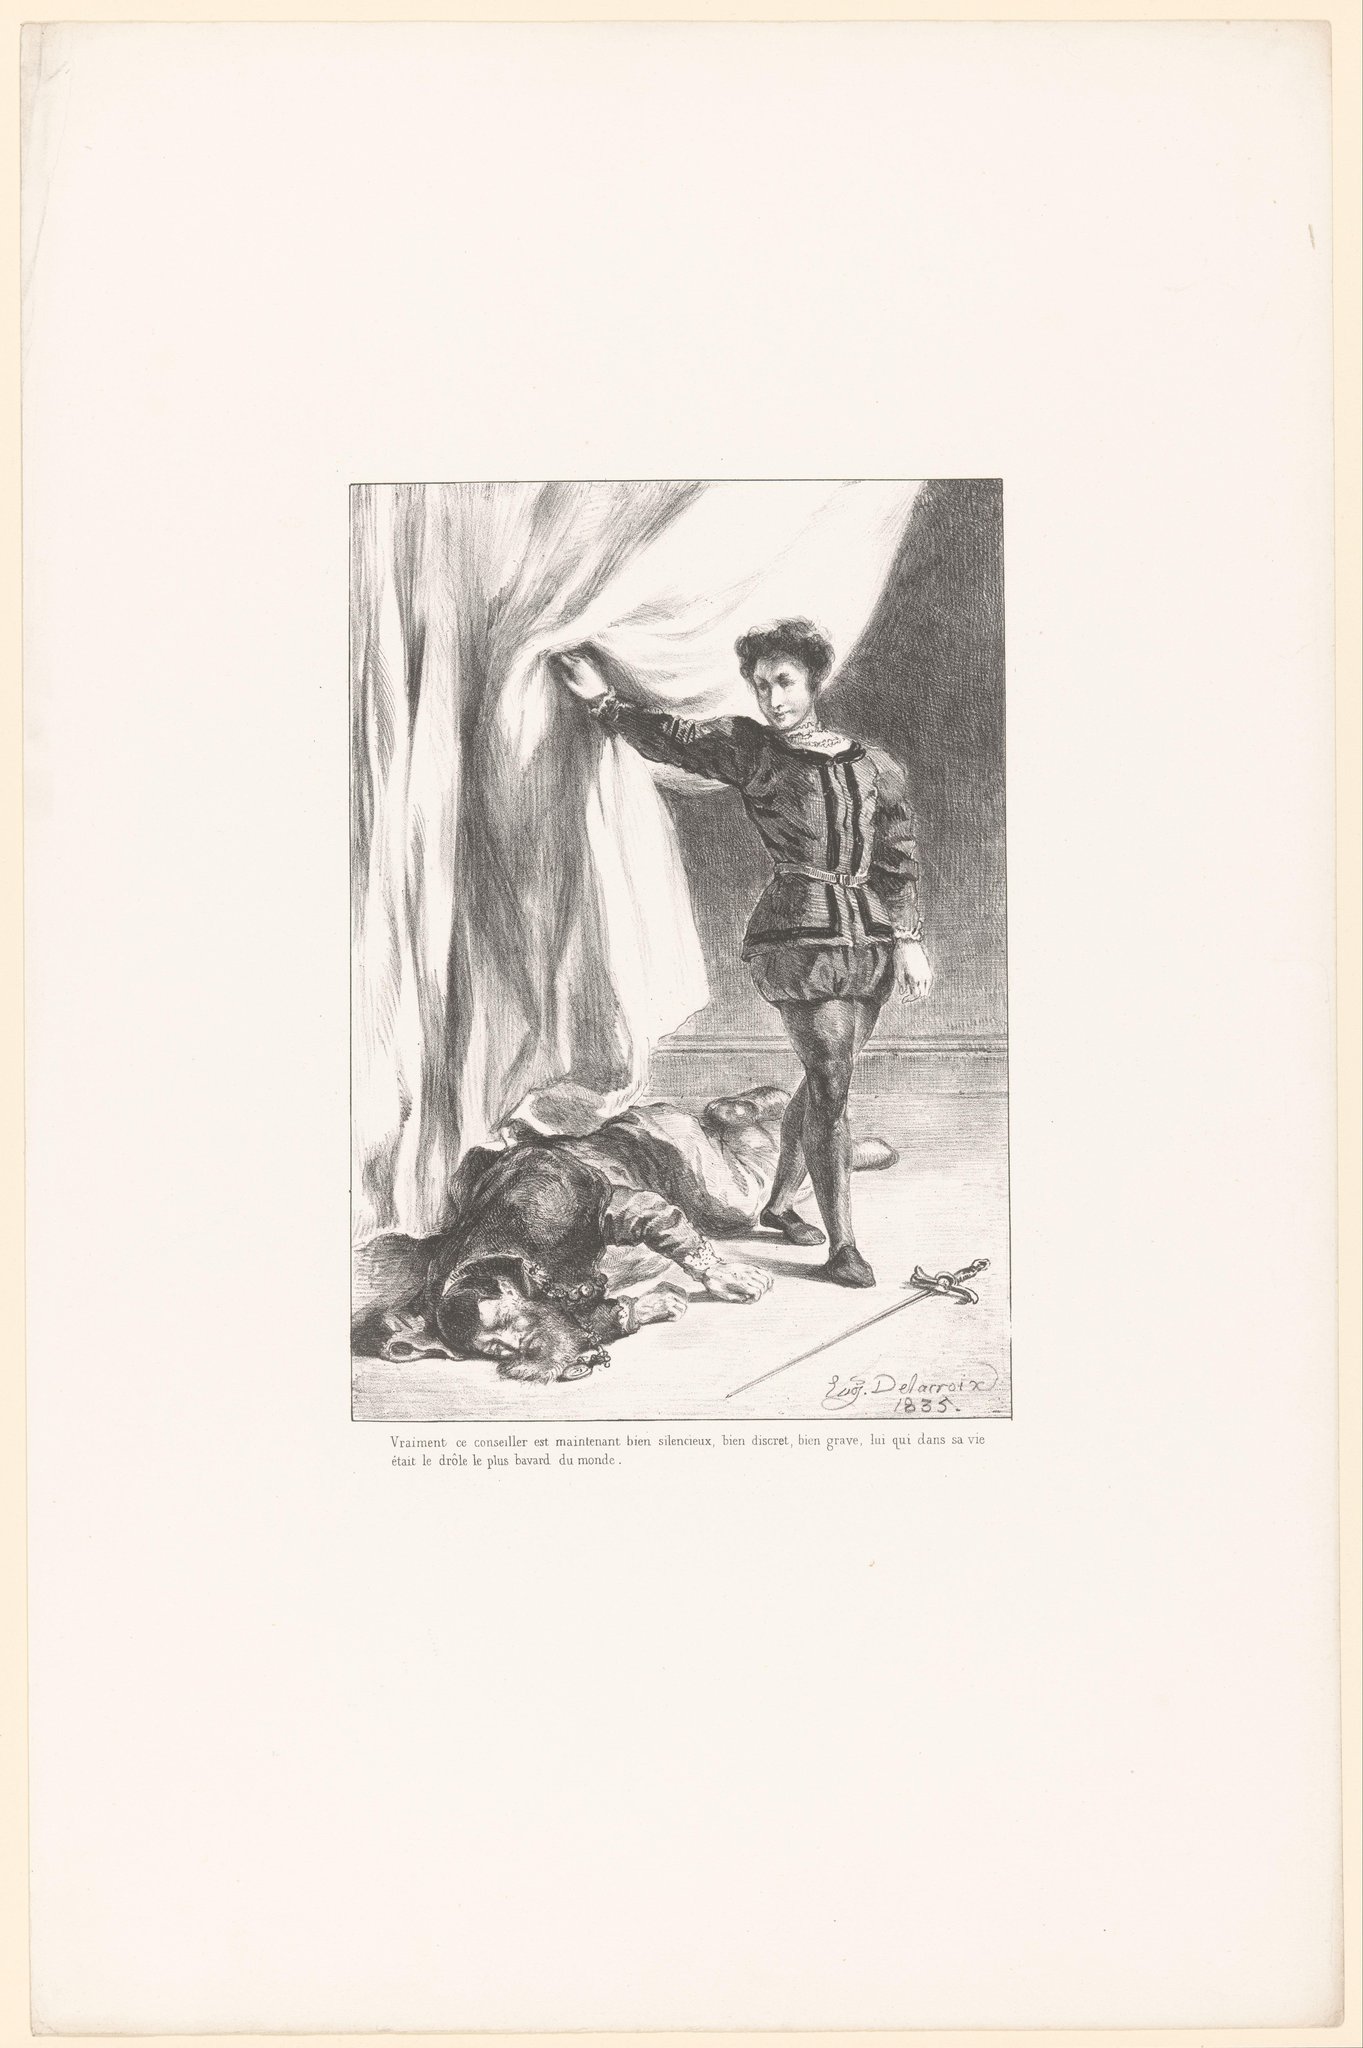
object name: print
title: Hamlet bij het lijk van Polonius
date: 1835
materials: paper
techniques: lithograph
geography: paris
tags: hamlet, prince of denmark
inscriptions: collector's mark: Lugt 2228a, collector's mark: Lugt 2760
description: Prent maakt deel uit van een omslag met veertien prenten.